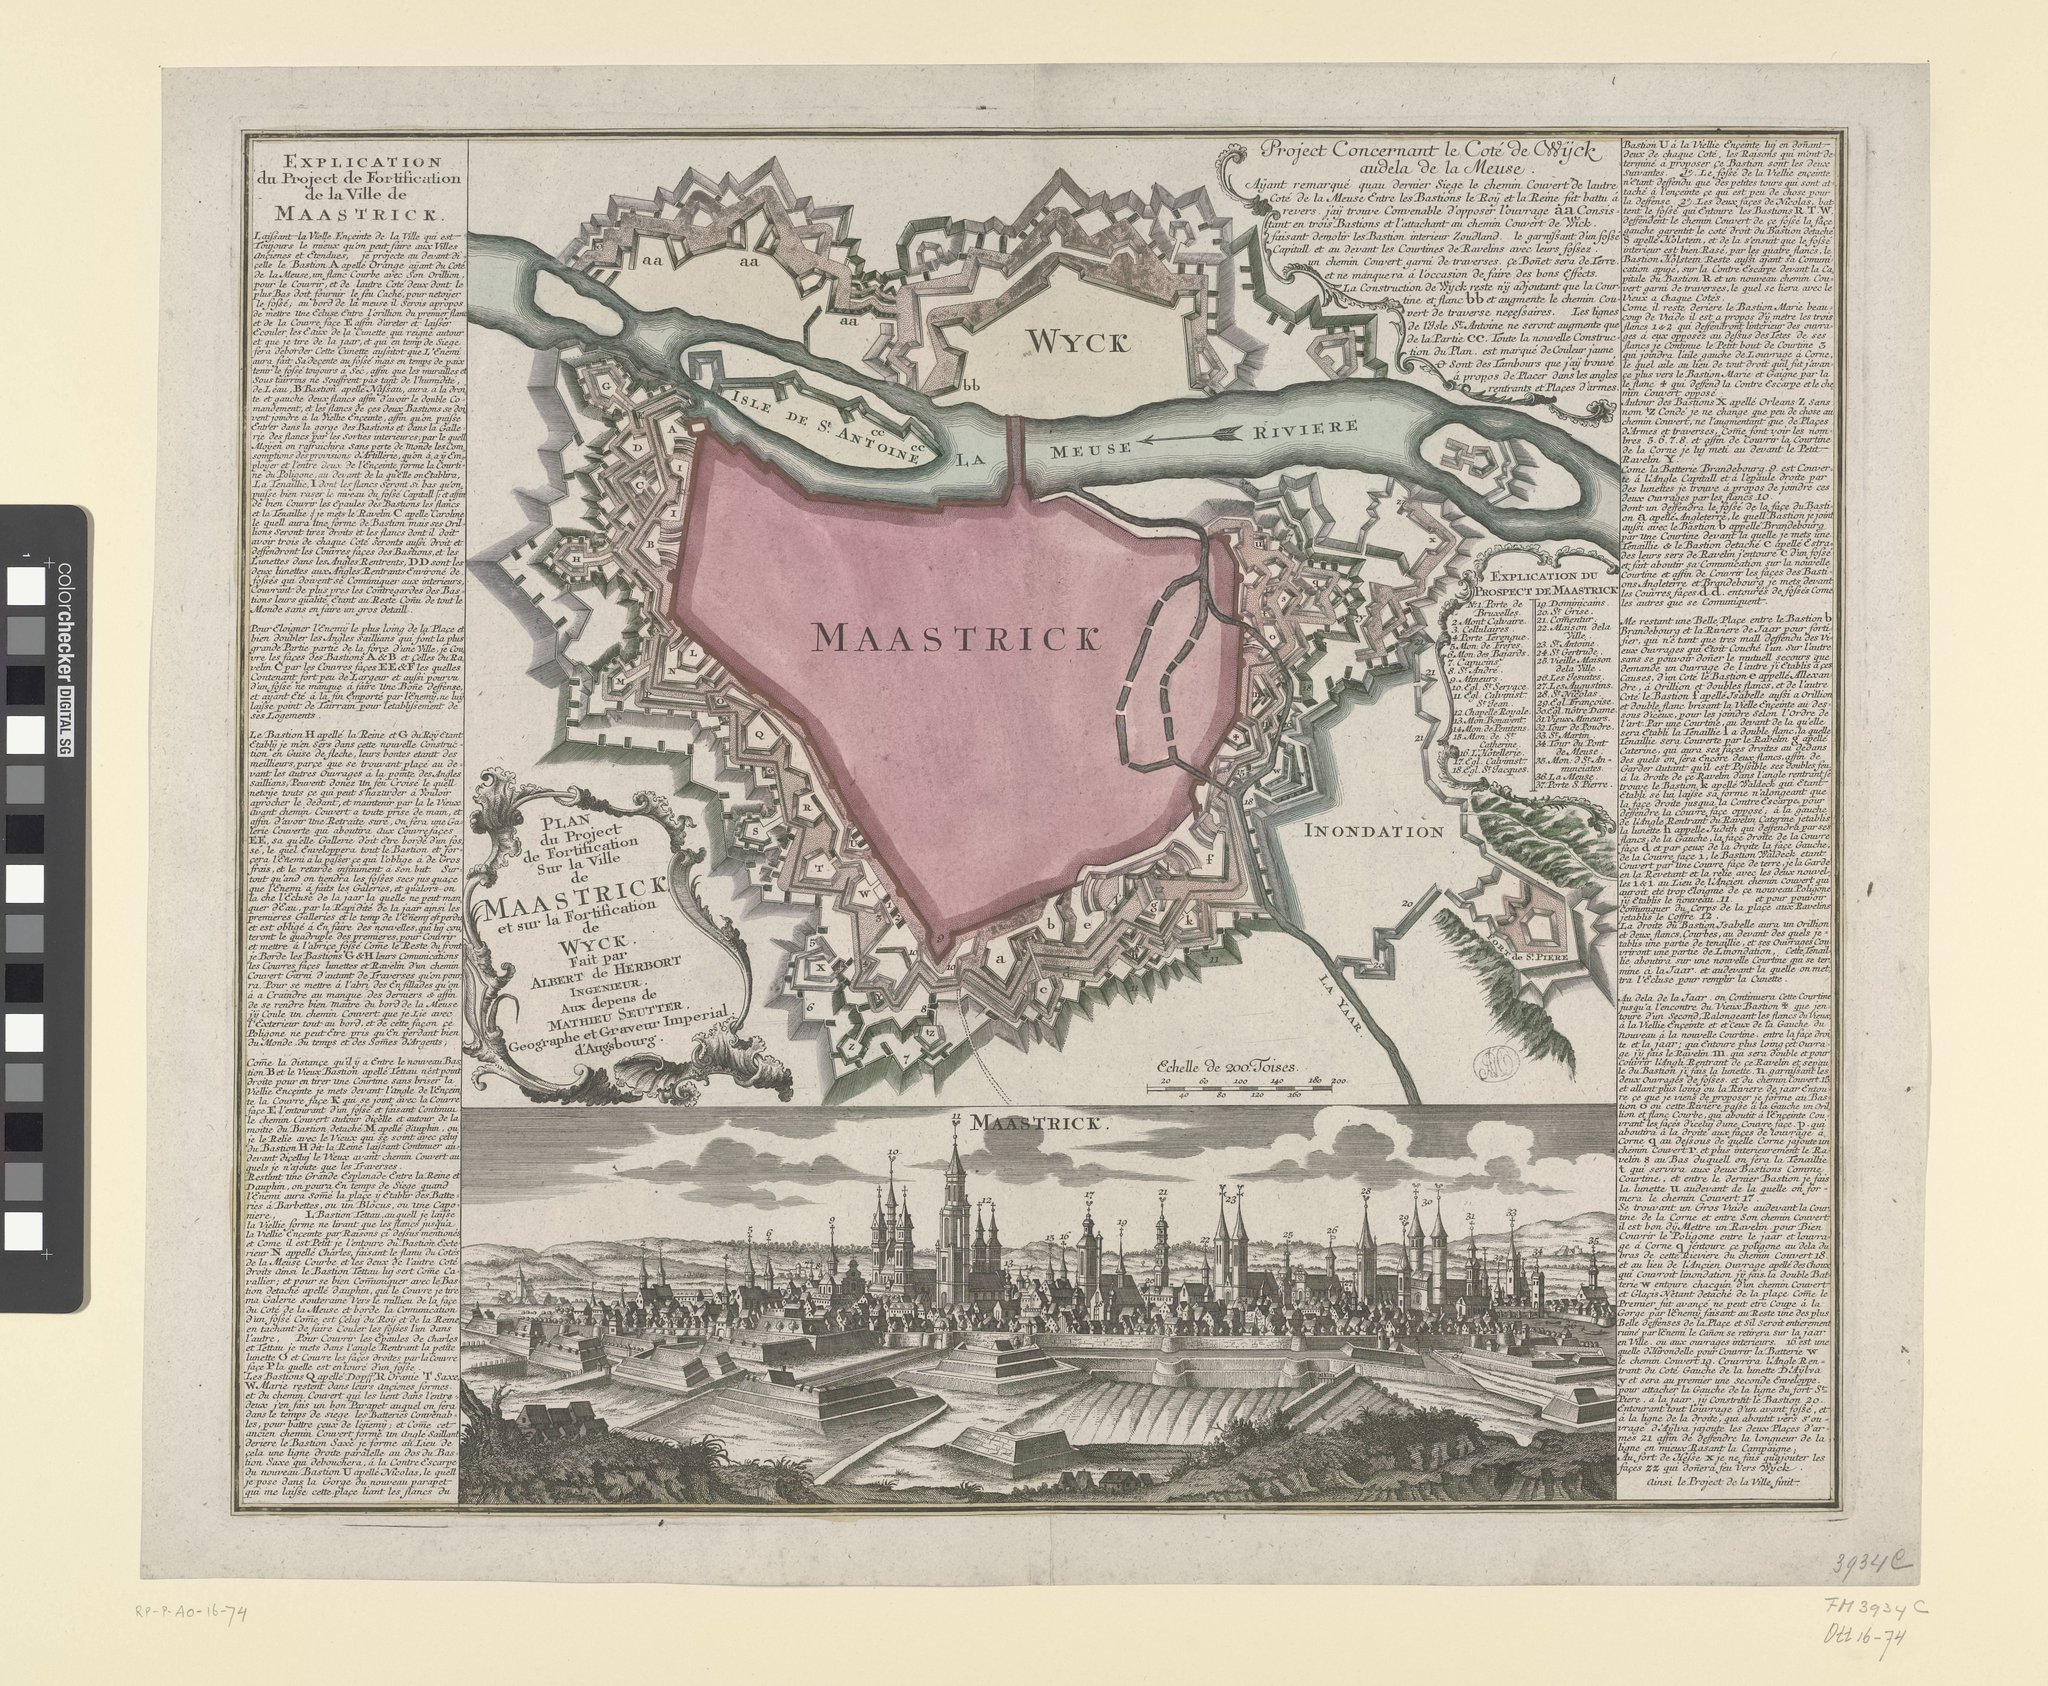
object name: print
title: Ontwerp voor verdedigingswerken om de stad Maastricht, 1748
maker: matthaeus seutter (iii)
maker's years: 1678-1757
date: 1748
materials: paper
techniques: engraving, etching, hand coloring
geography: augsburg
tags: fortress, maps of cities, maastricht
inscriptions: collector's mark: Lugt 195, collector's mark: Lugt 2228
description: Plan voor nieuwe verdedigingswerken om Maastricht en Wijk aan de overzijde van de Maas, ten tijde van het beleg van de stad door de Fransen onder Maurits van Saksen en Lowendal vanaf 15 april 1748. Fortificaties ontworpen door de ingenieur Albert de Herbort.